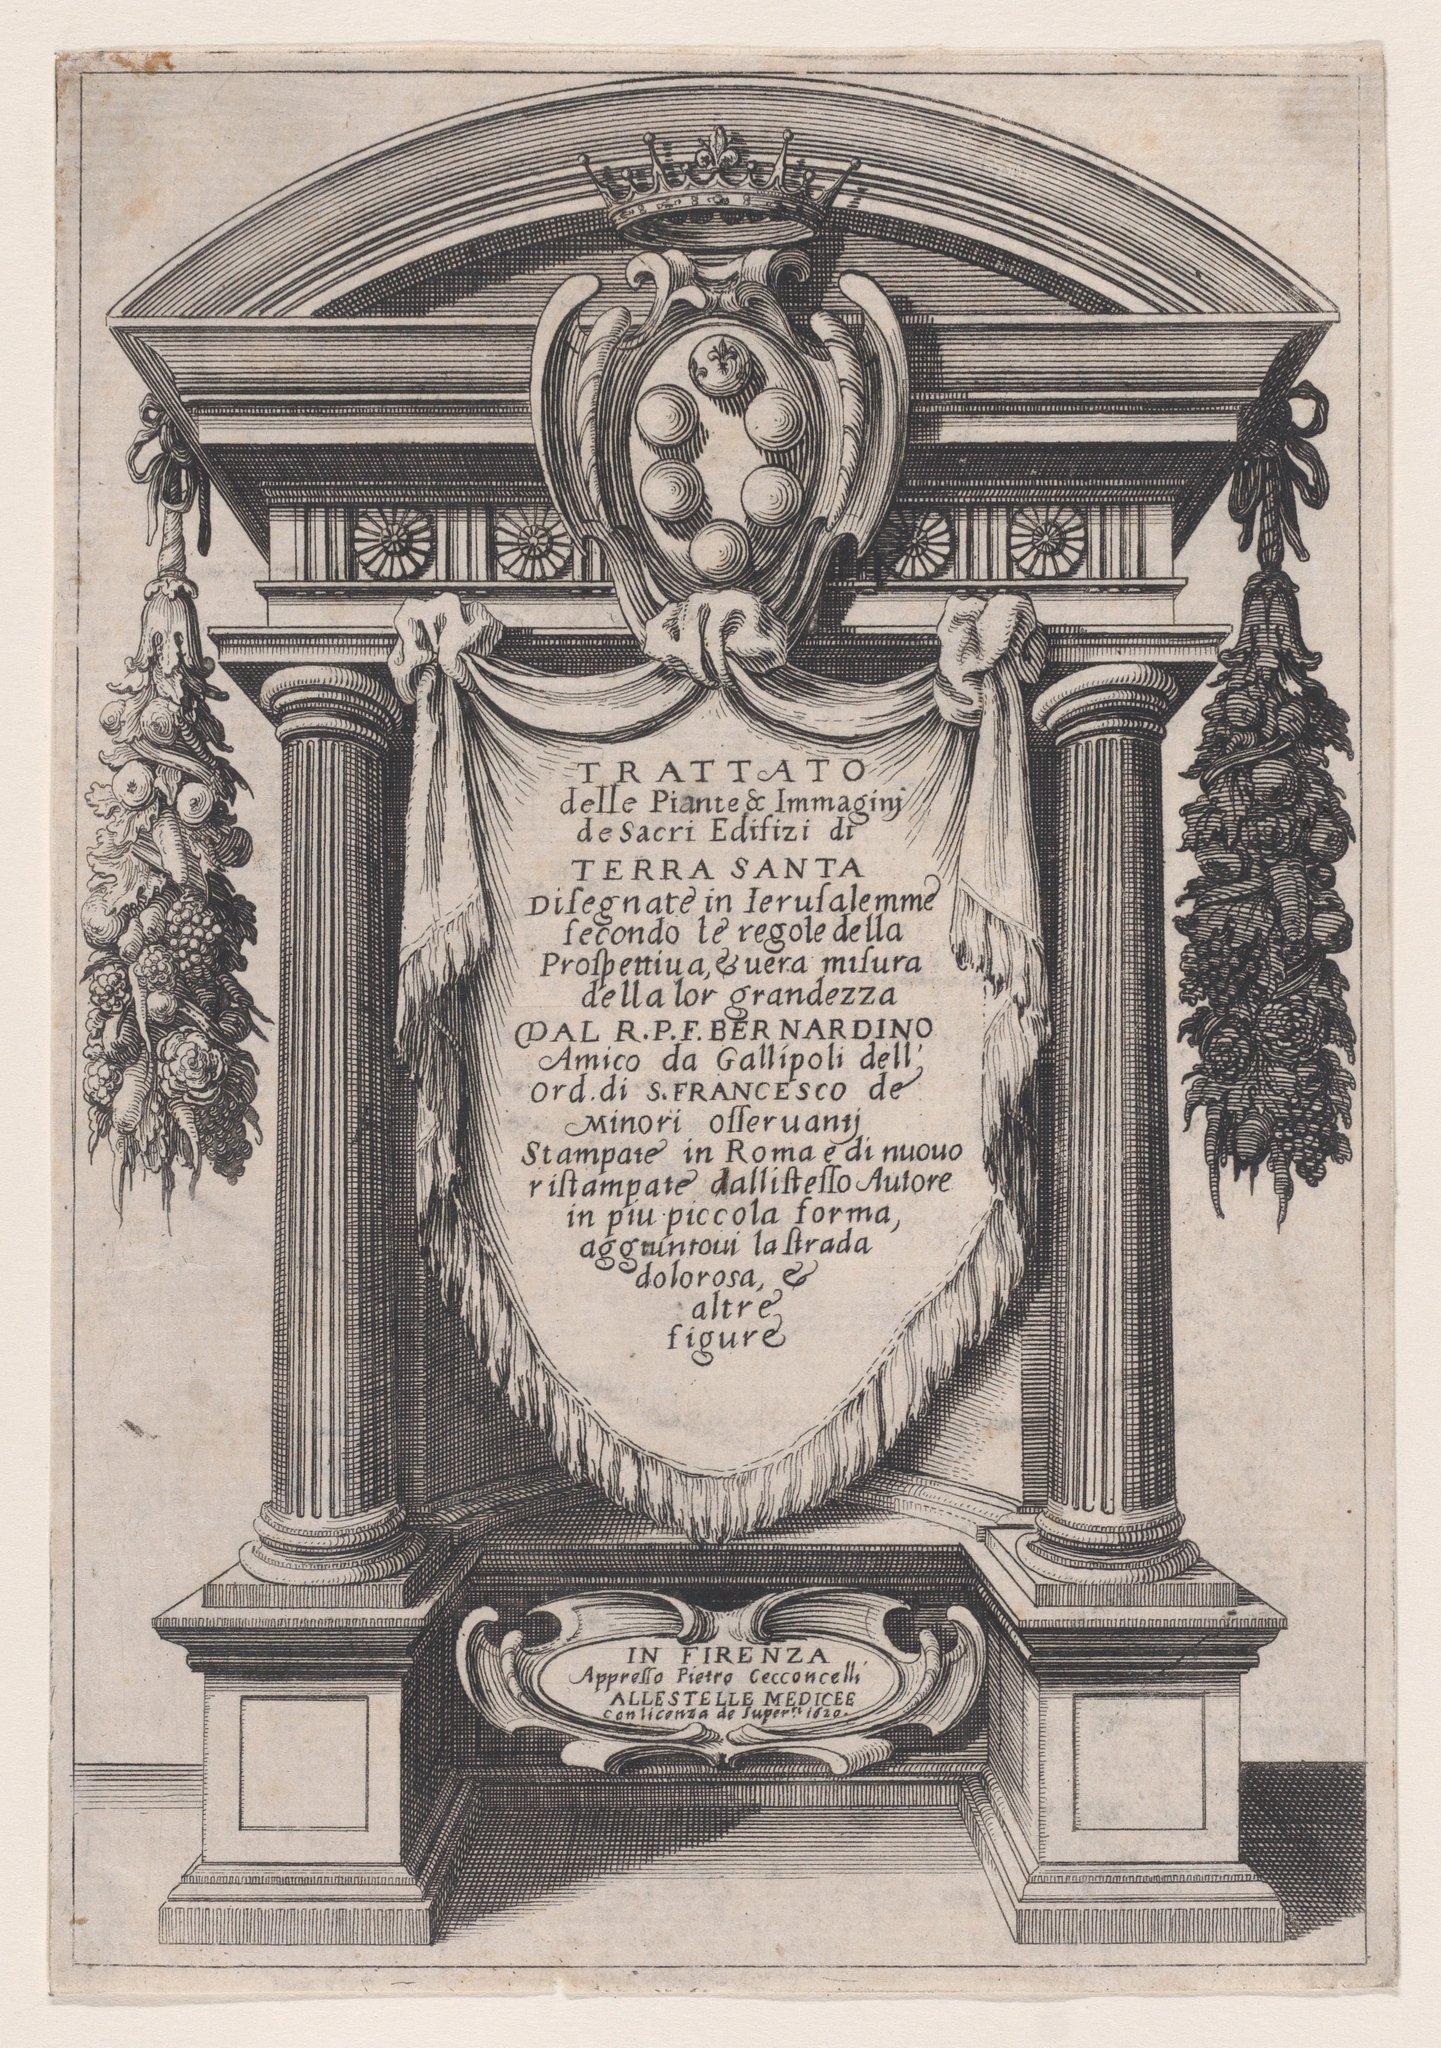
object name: print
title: Frontispiece, from "Trattato delle Piante & Immagini de Sacri Edifizi di Terra Santa" (Treatise of the Plans & Images of the Sacred Buildings of the Holy Land)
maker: jacques callot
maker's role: artist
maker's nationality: french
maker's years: 1592-1635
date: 1620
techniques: engraving, etching